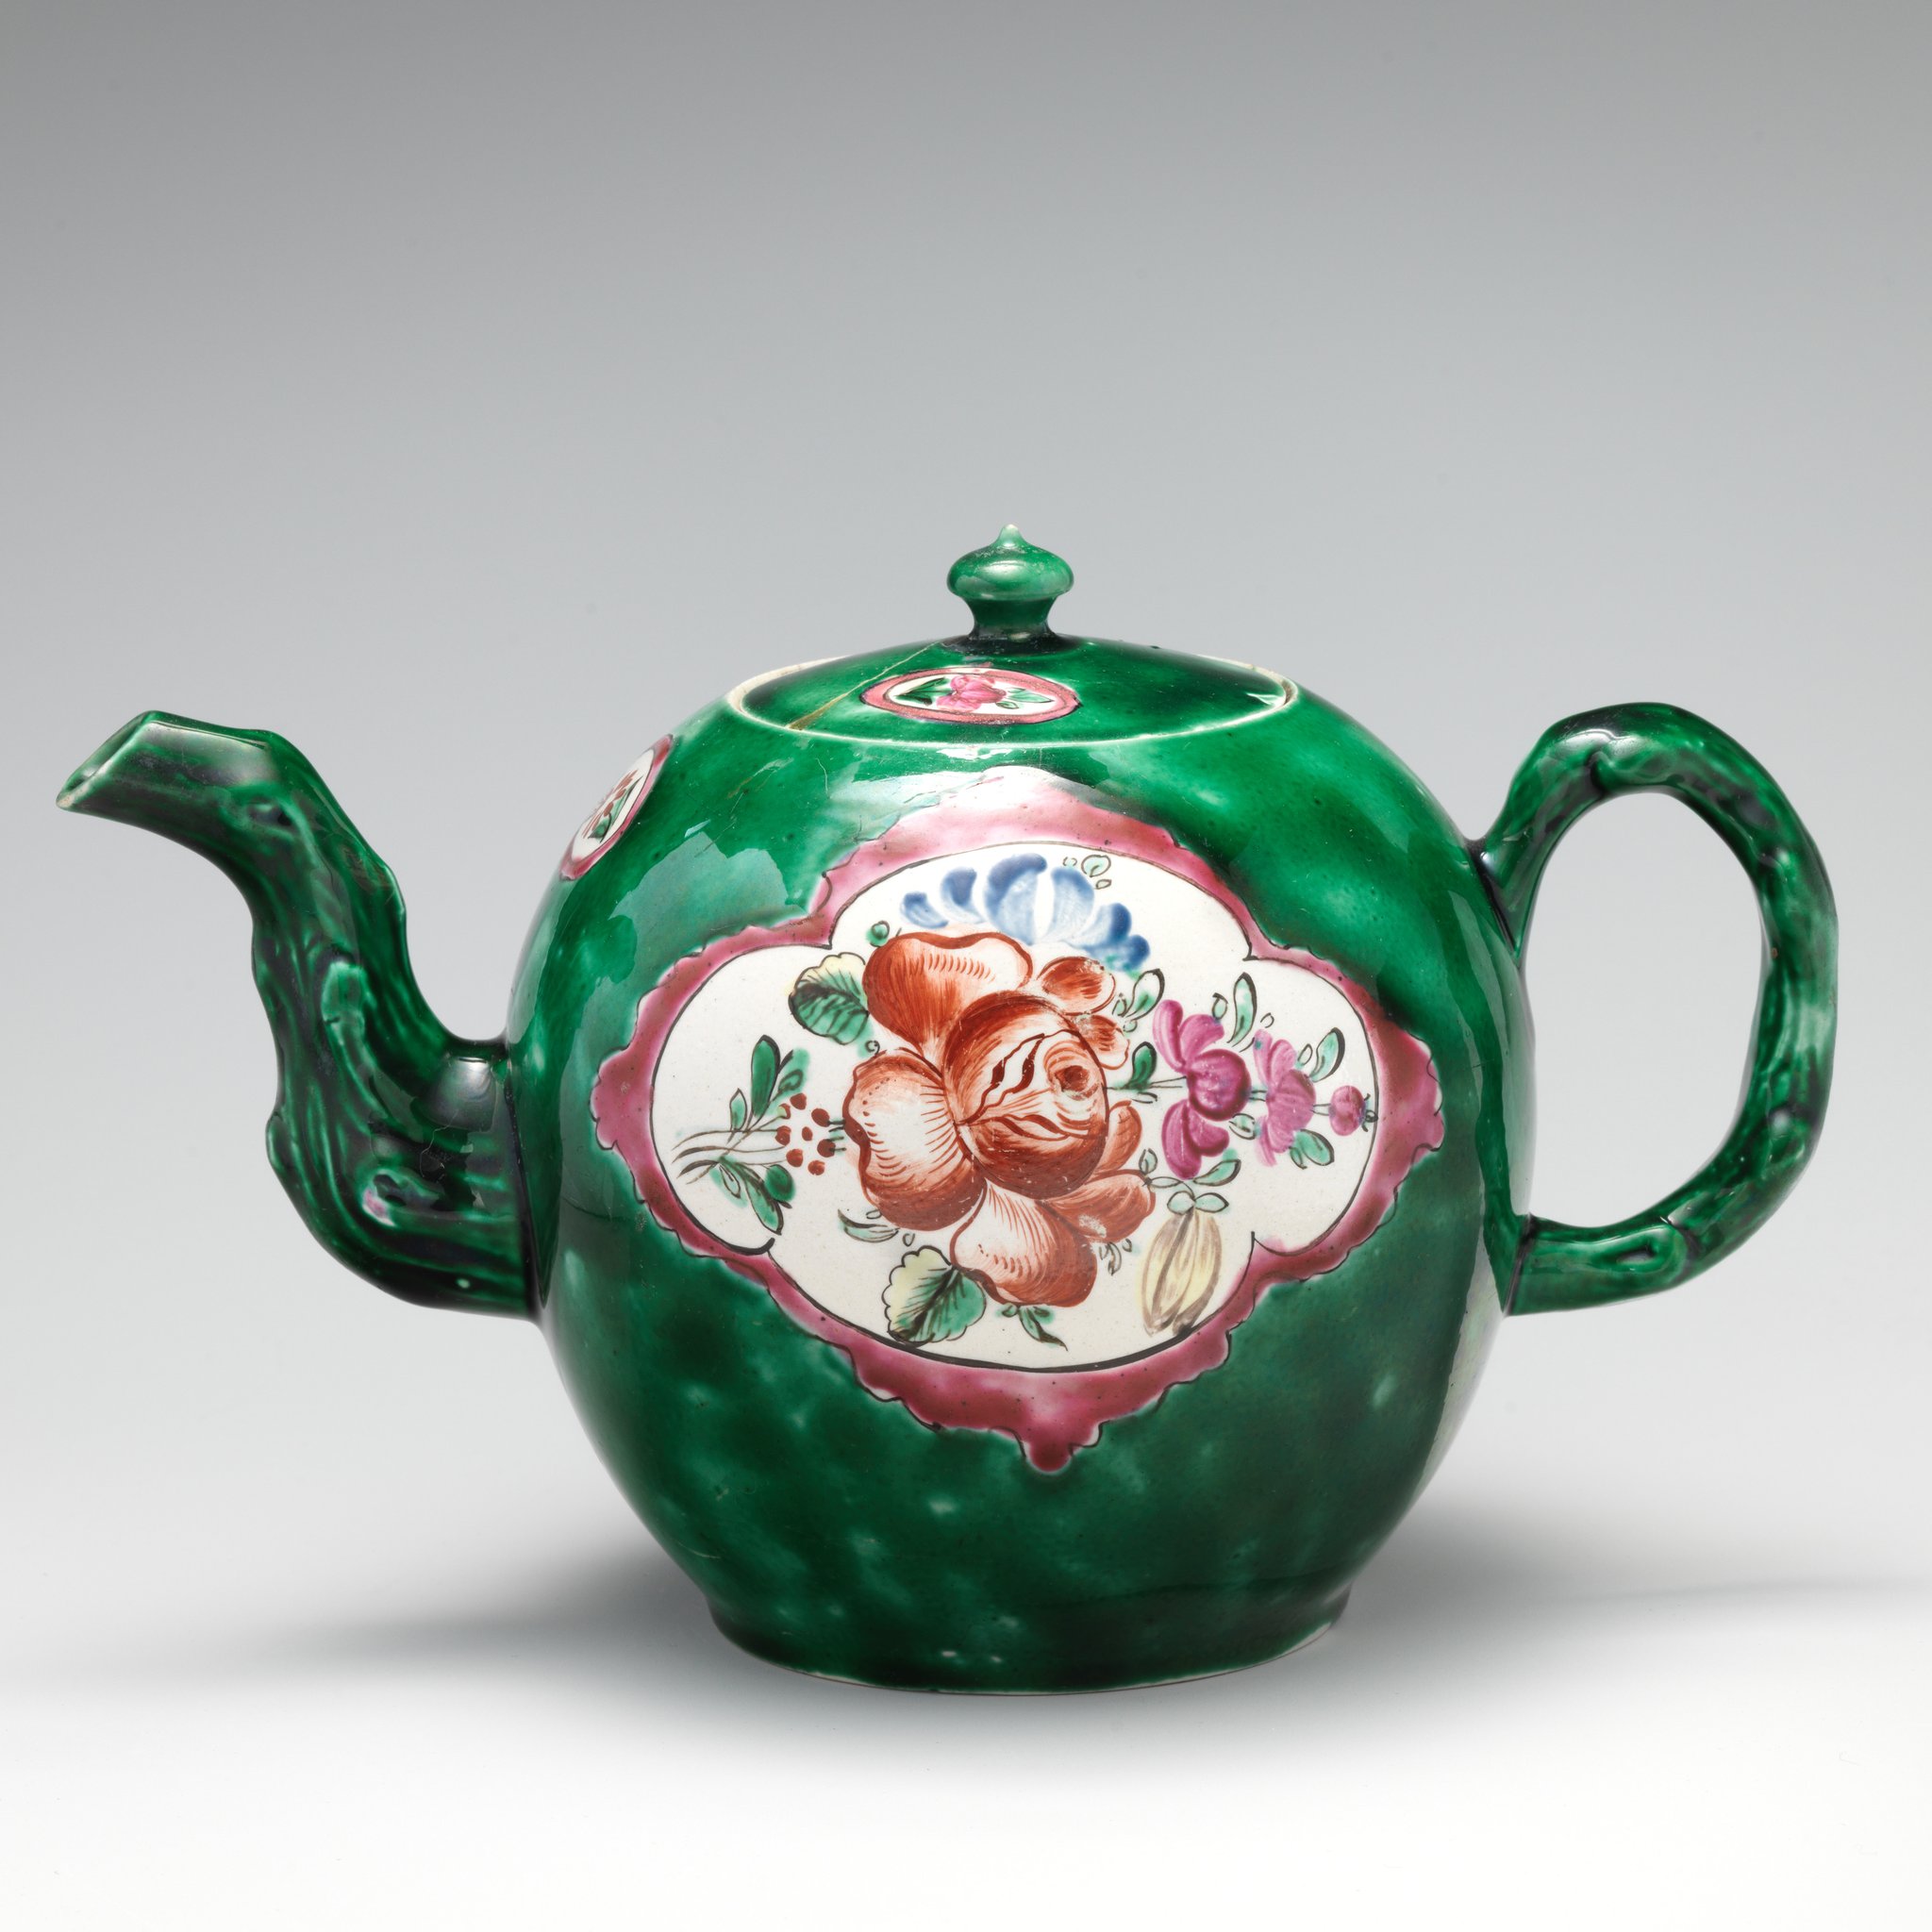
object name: teapot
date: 1765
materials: stoneware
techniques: salt glaze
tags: flowers